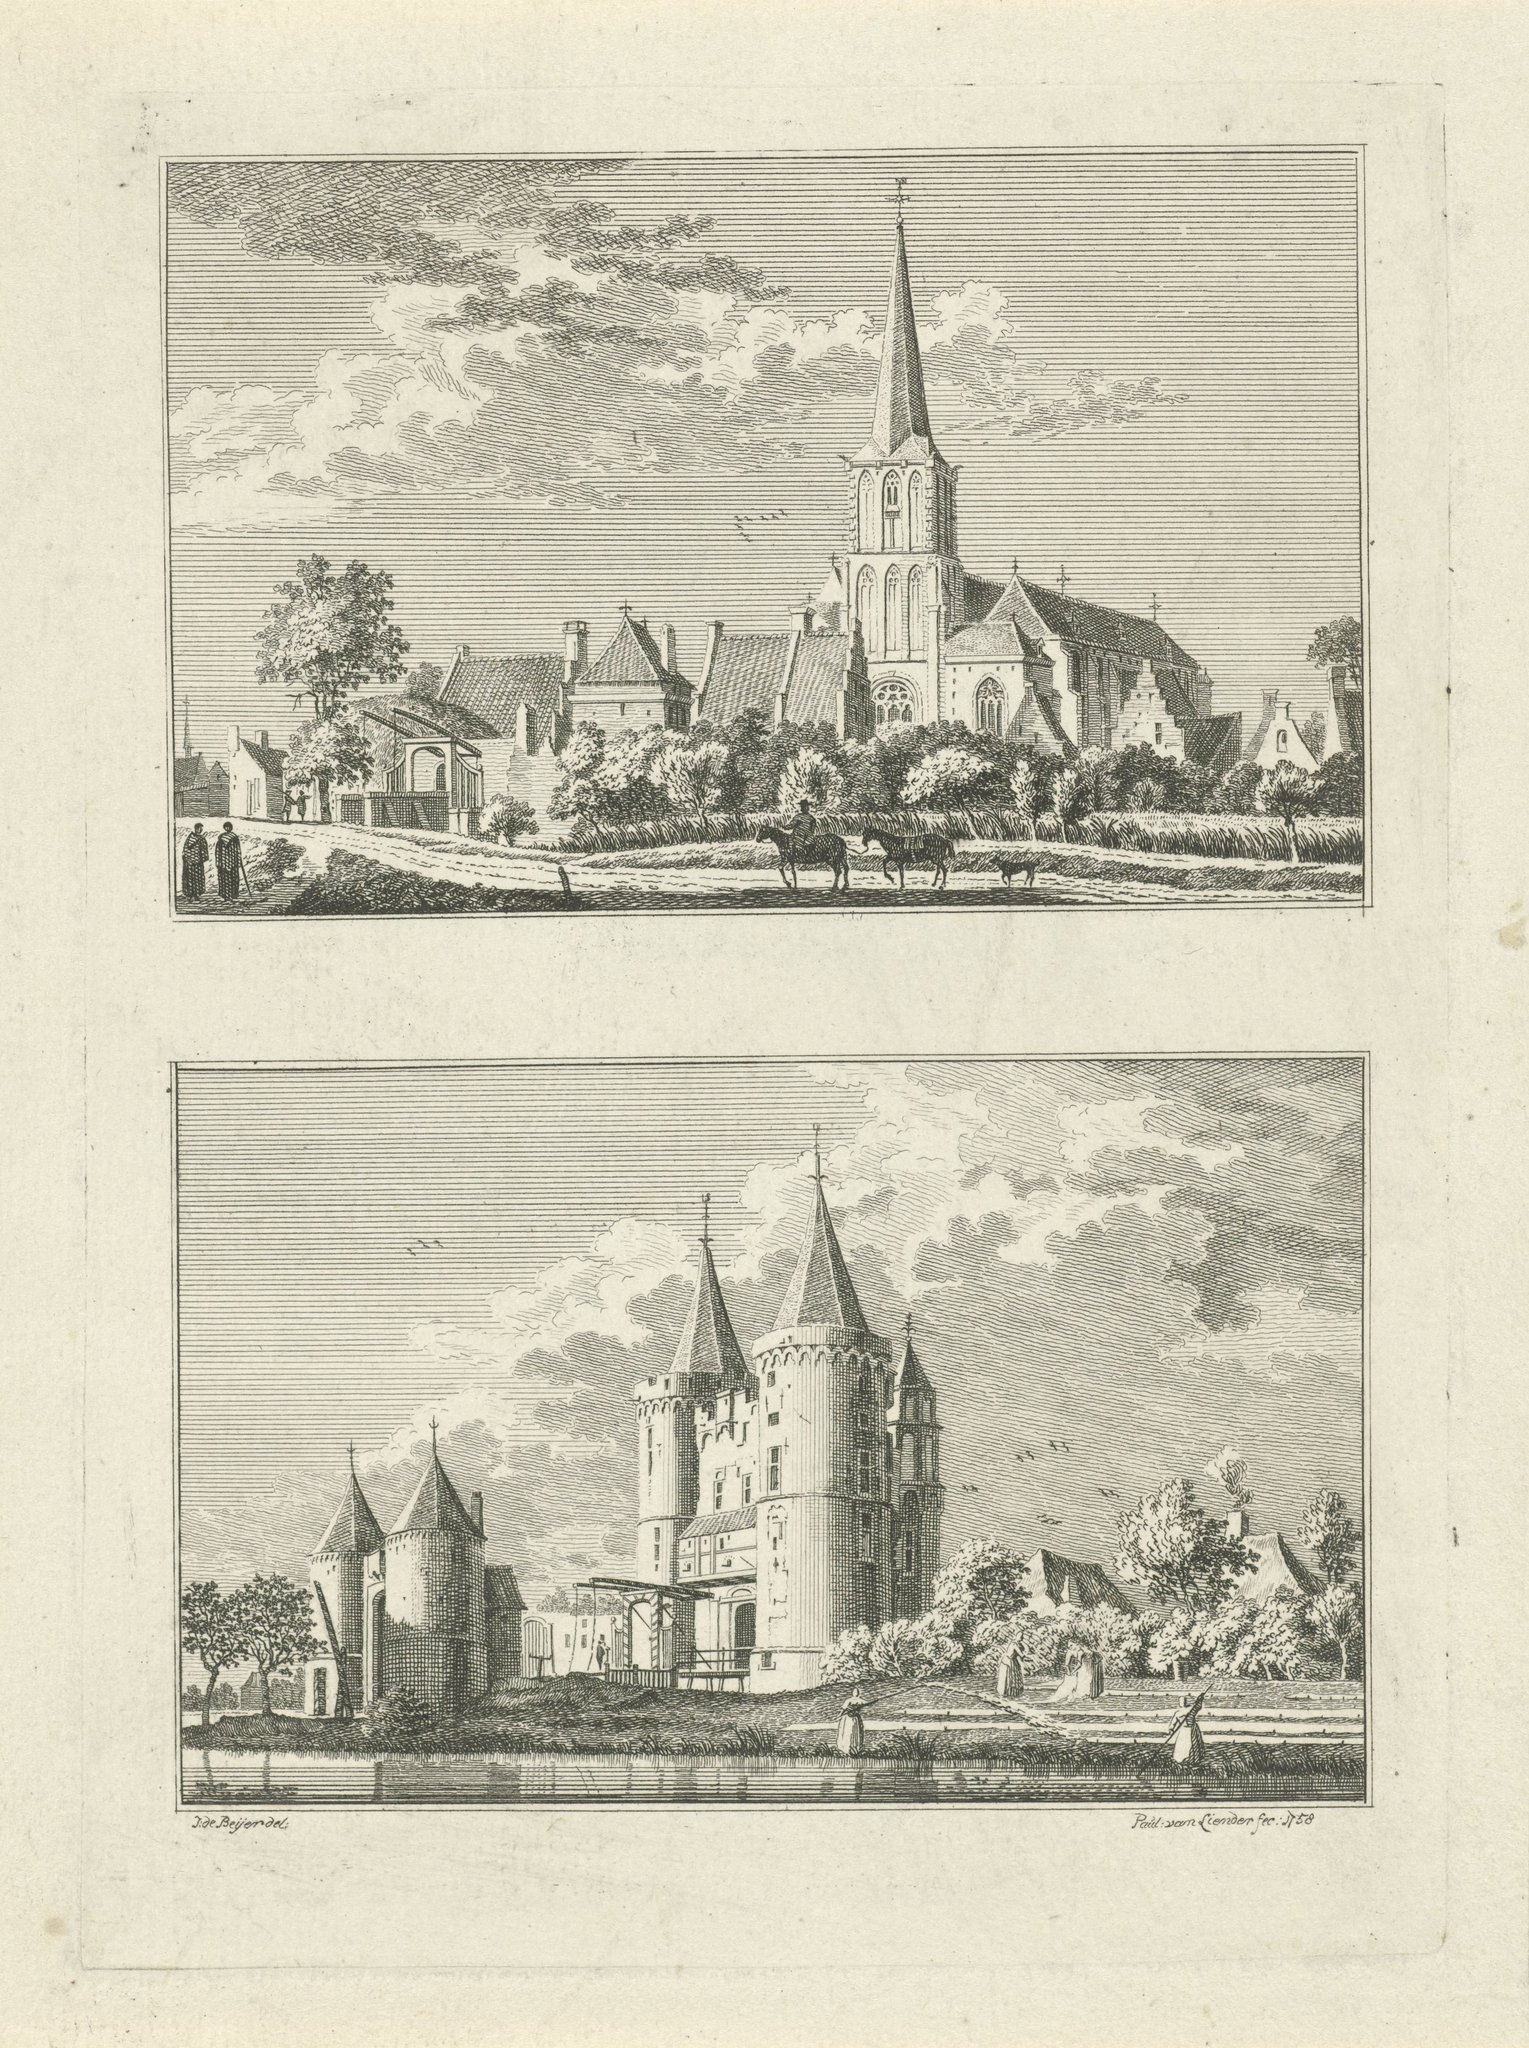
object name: print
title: Dorps- en stadsgezichten te Kleef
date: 1758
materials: paper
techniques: etching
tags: city-view, and landscape with man-made constructions, city-gate, kalkar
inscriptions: collector's mark: Lugt 2228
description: Twee voorstellingen van één plaat. Gezichten op de Kleefse poort (boven) en de Hanselersche poort (onder) te Kalkar, Duitsland. De prent maakt deel uit van een 100-delige serie met gezichten op dorpen en steden te Kleef.